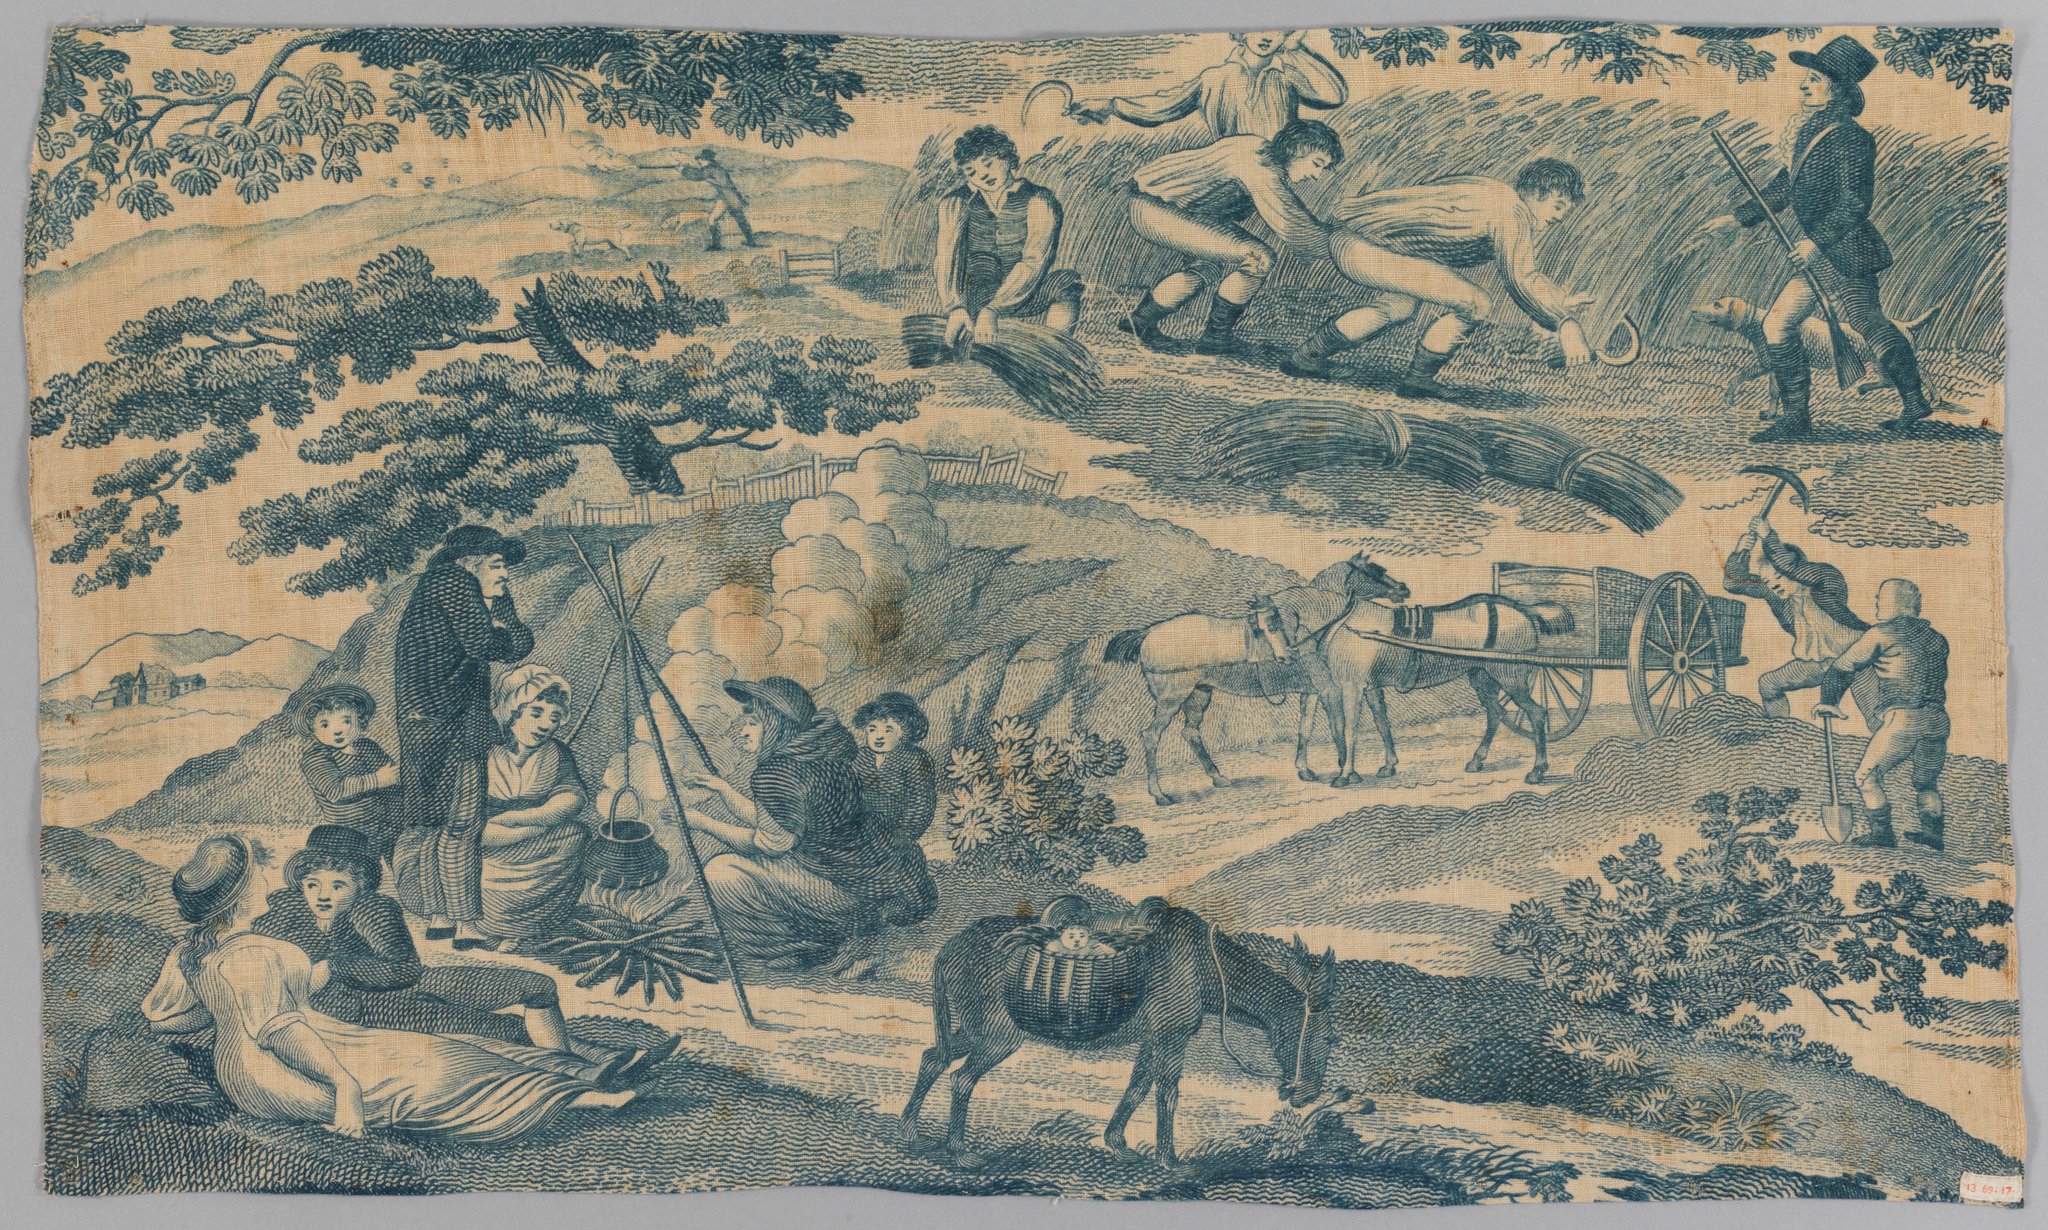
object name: piece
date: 1805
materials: cotton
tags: human figures,hunting,dogs,donkeys,horses,landscapes,farmers,harvesting,cooking